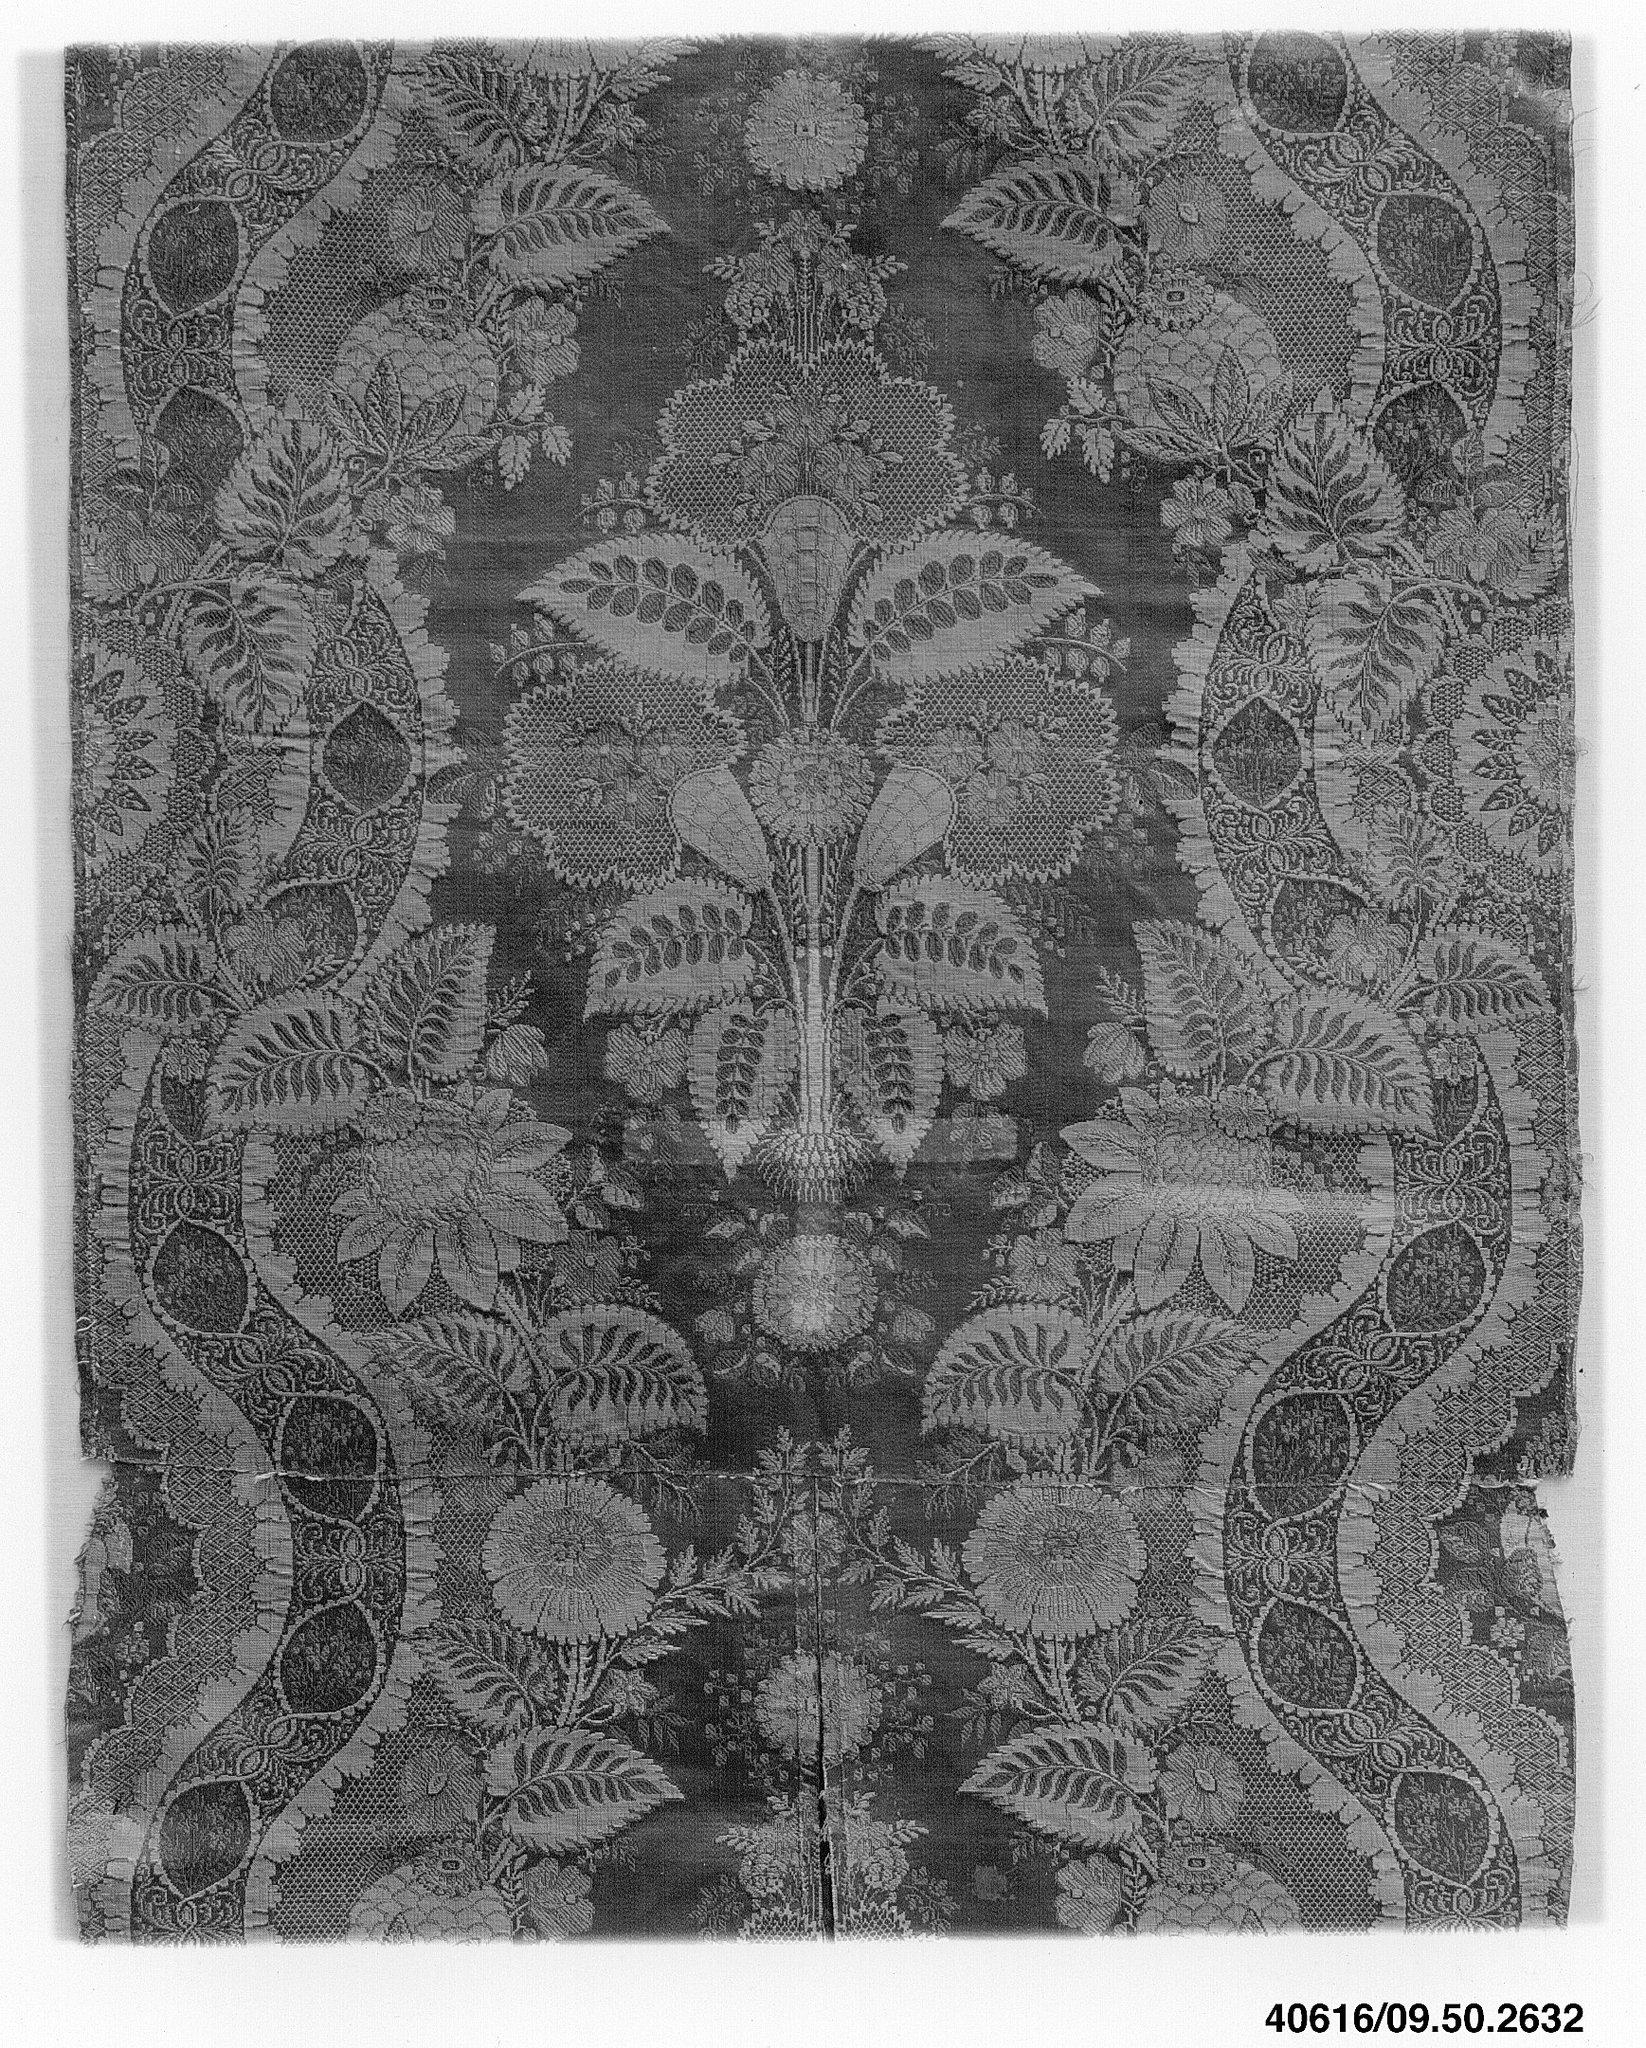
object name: piece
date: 1725-1730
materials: silk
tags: flowers,leaves